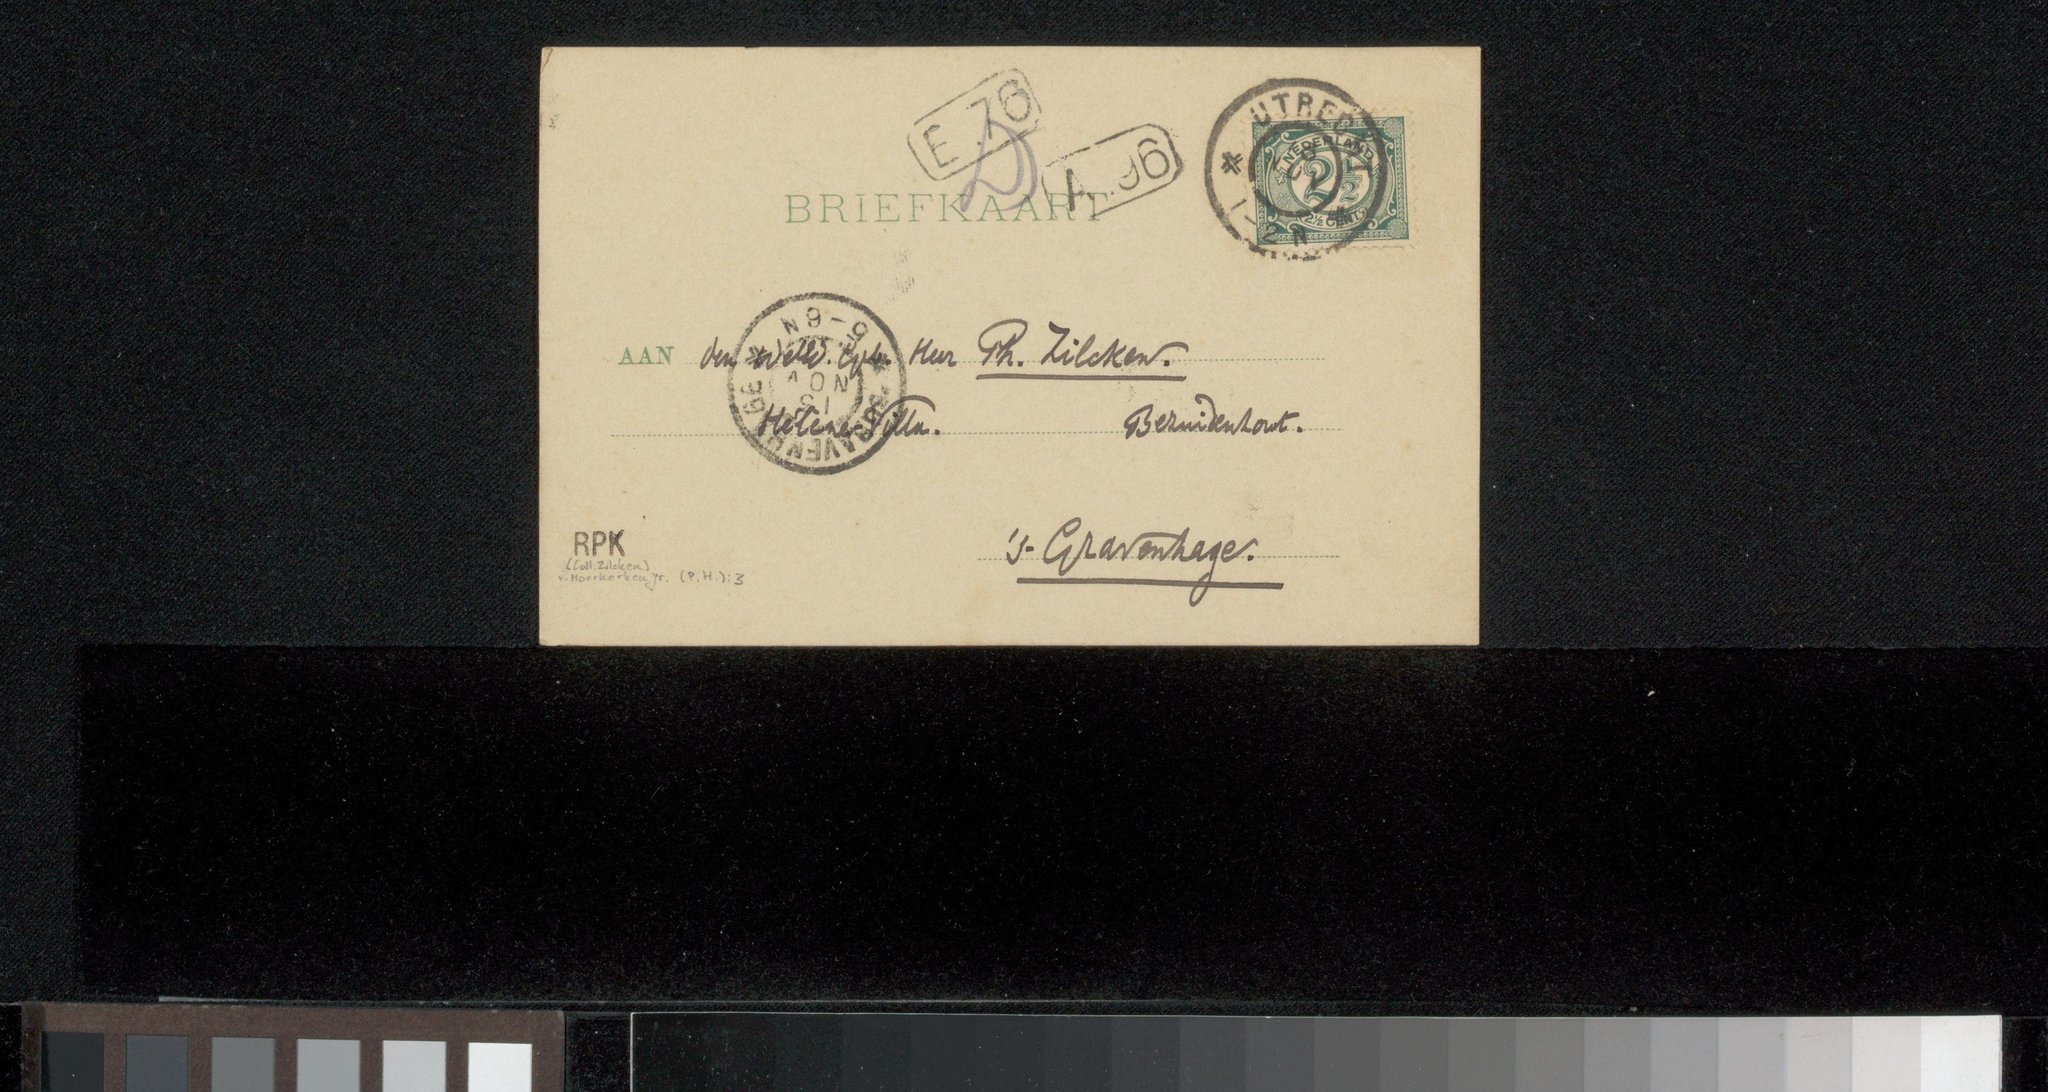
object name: postcard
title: Briefkaart aan Philip Zilcken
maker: pieter hendrik van moerkerken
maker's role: print maker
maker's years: 1877-1951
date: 1901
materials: cardboard, ink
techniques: pen, writing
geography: utrecht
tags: den bosch, print maker, antoon derkinderen, draughtsman, pierre joseph hubert cuypers, utrecht, the hague, philip zilcken, photography, cinematography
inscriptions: collector's mark: ‘RPK’